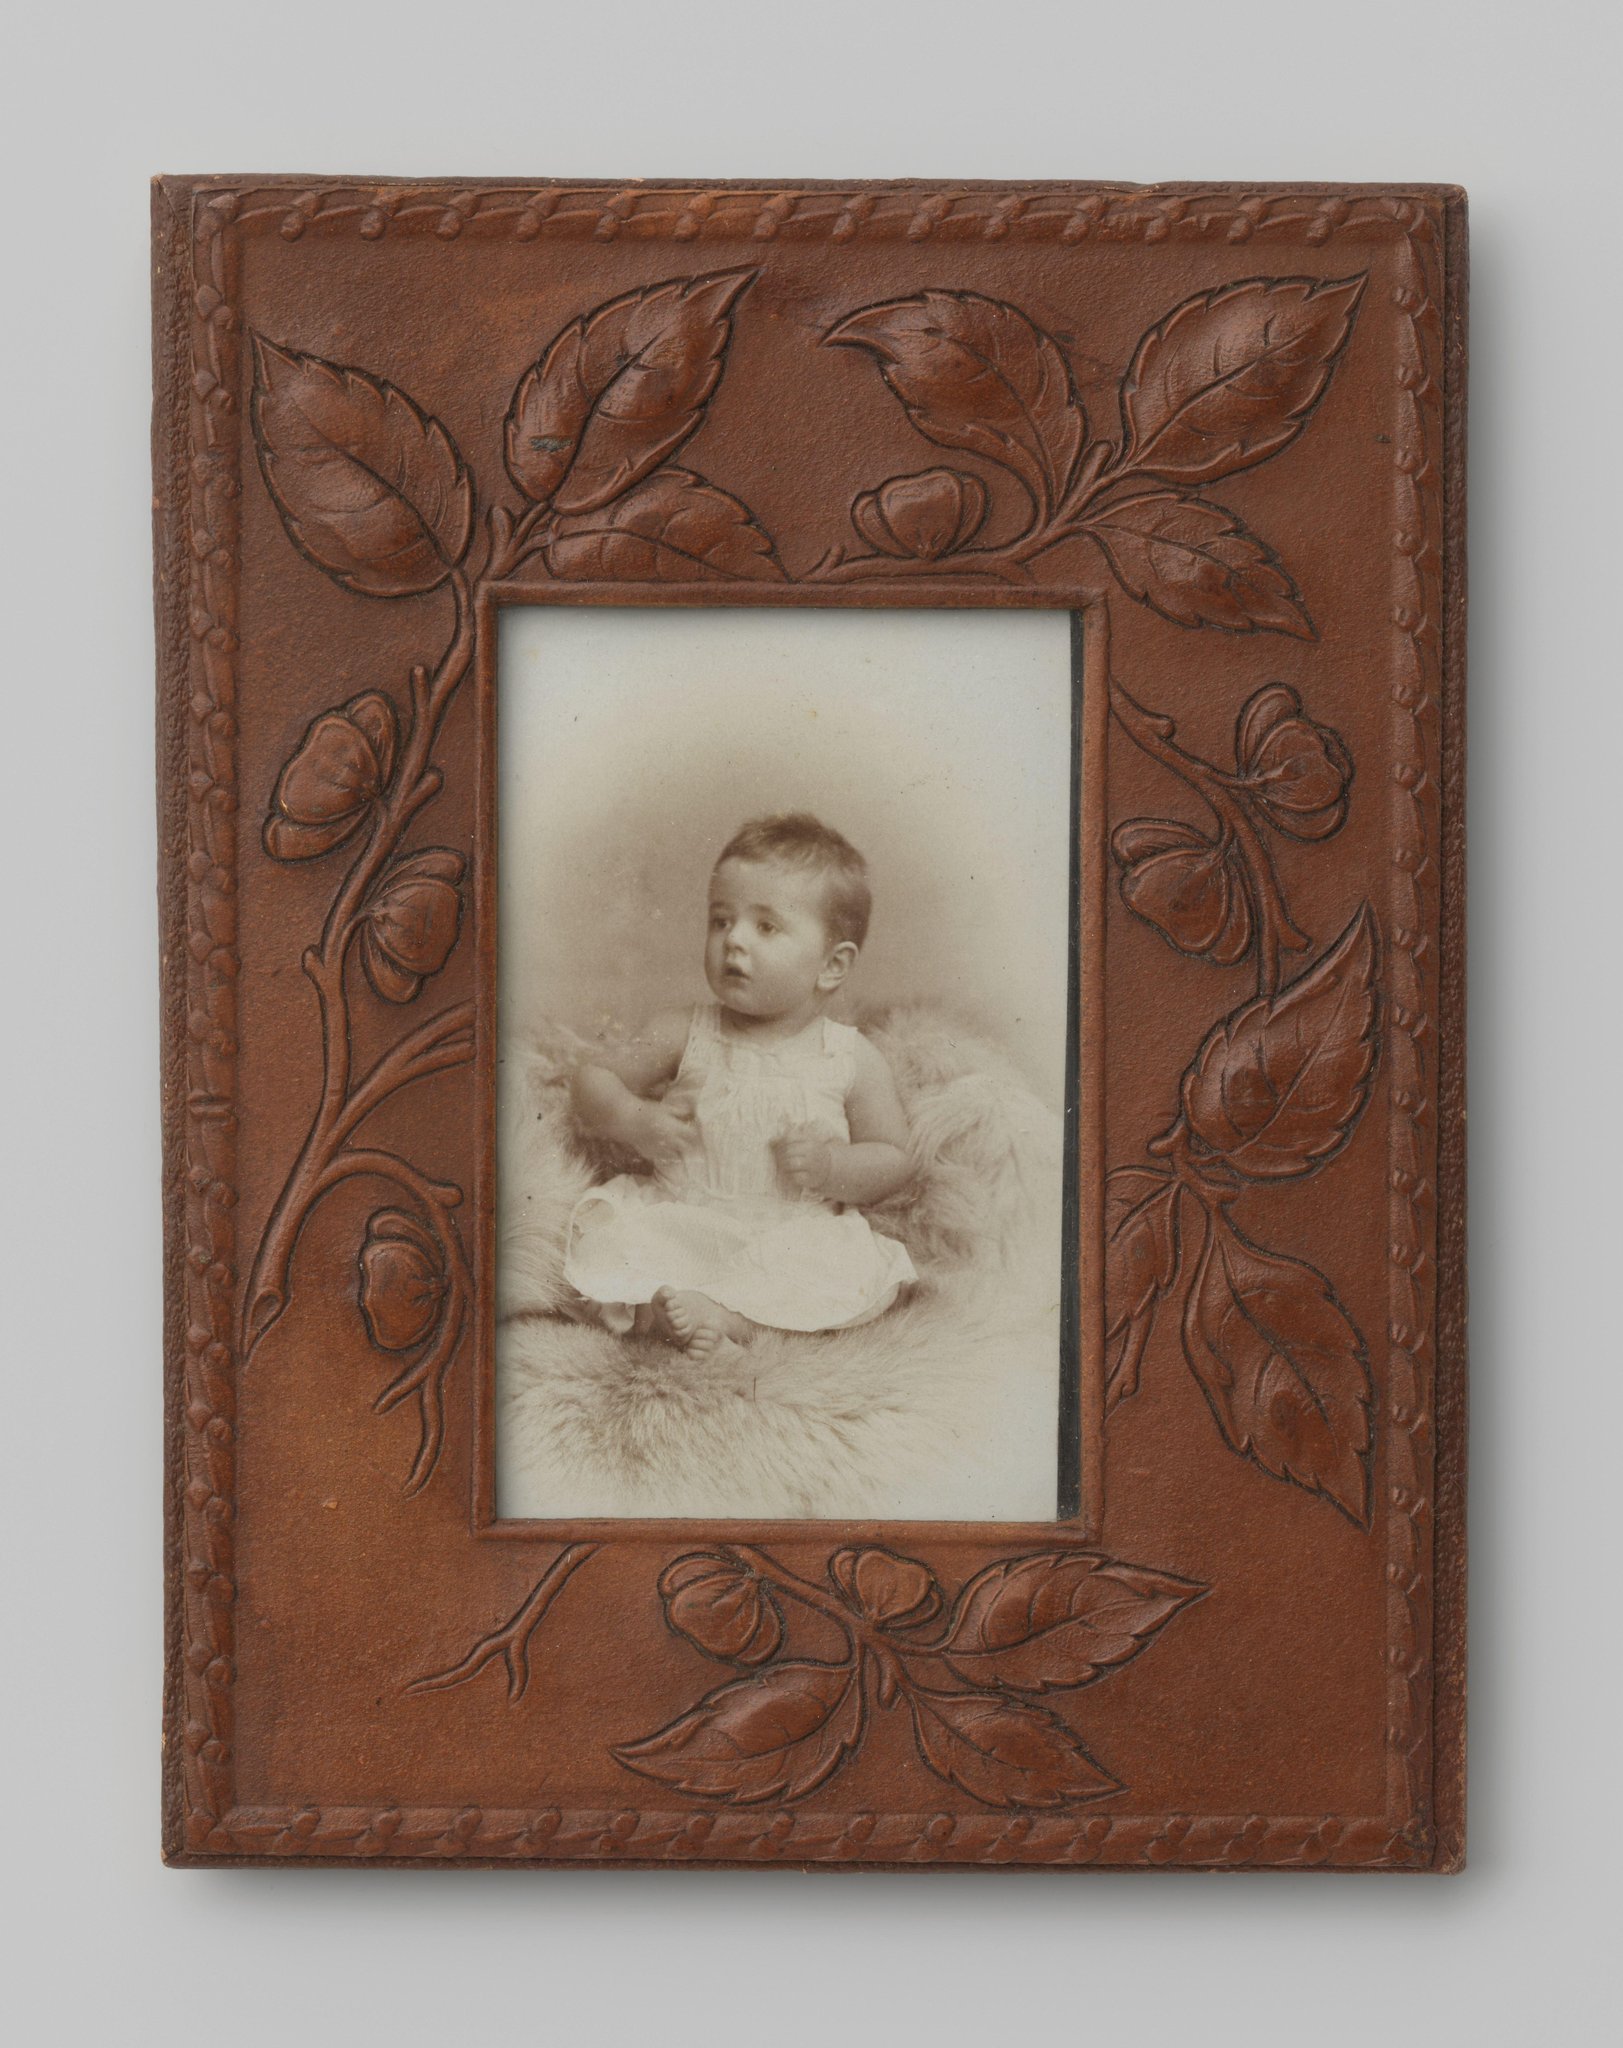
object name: frame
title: Portret van een onbekende baby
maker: Anonymous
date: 1880-1900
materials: paper, cardboard, glass, leather, metal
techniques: gelatin silver print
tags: anonymous historical person portrayed, infant, baby